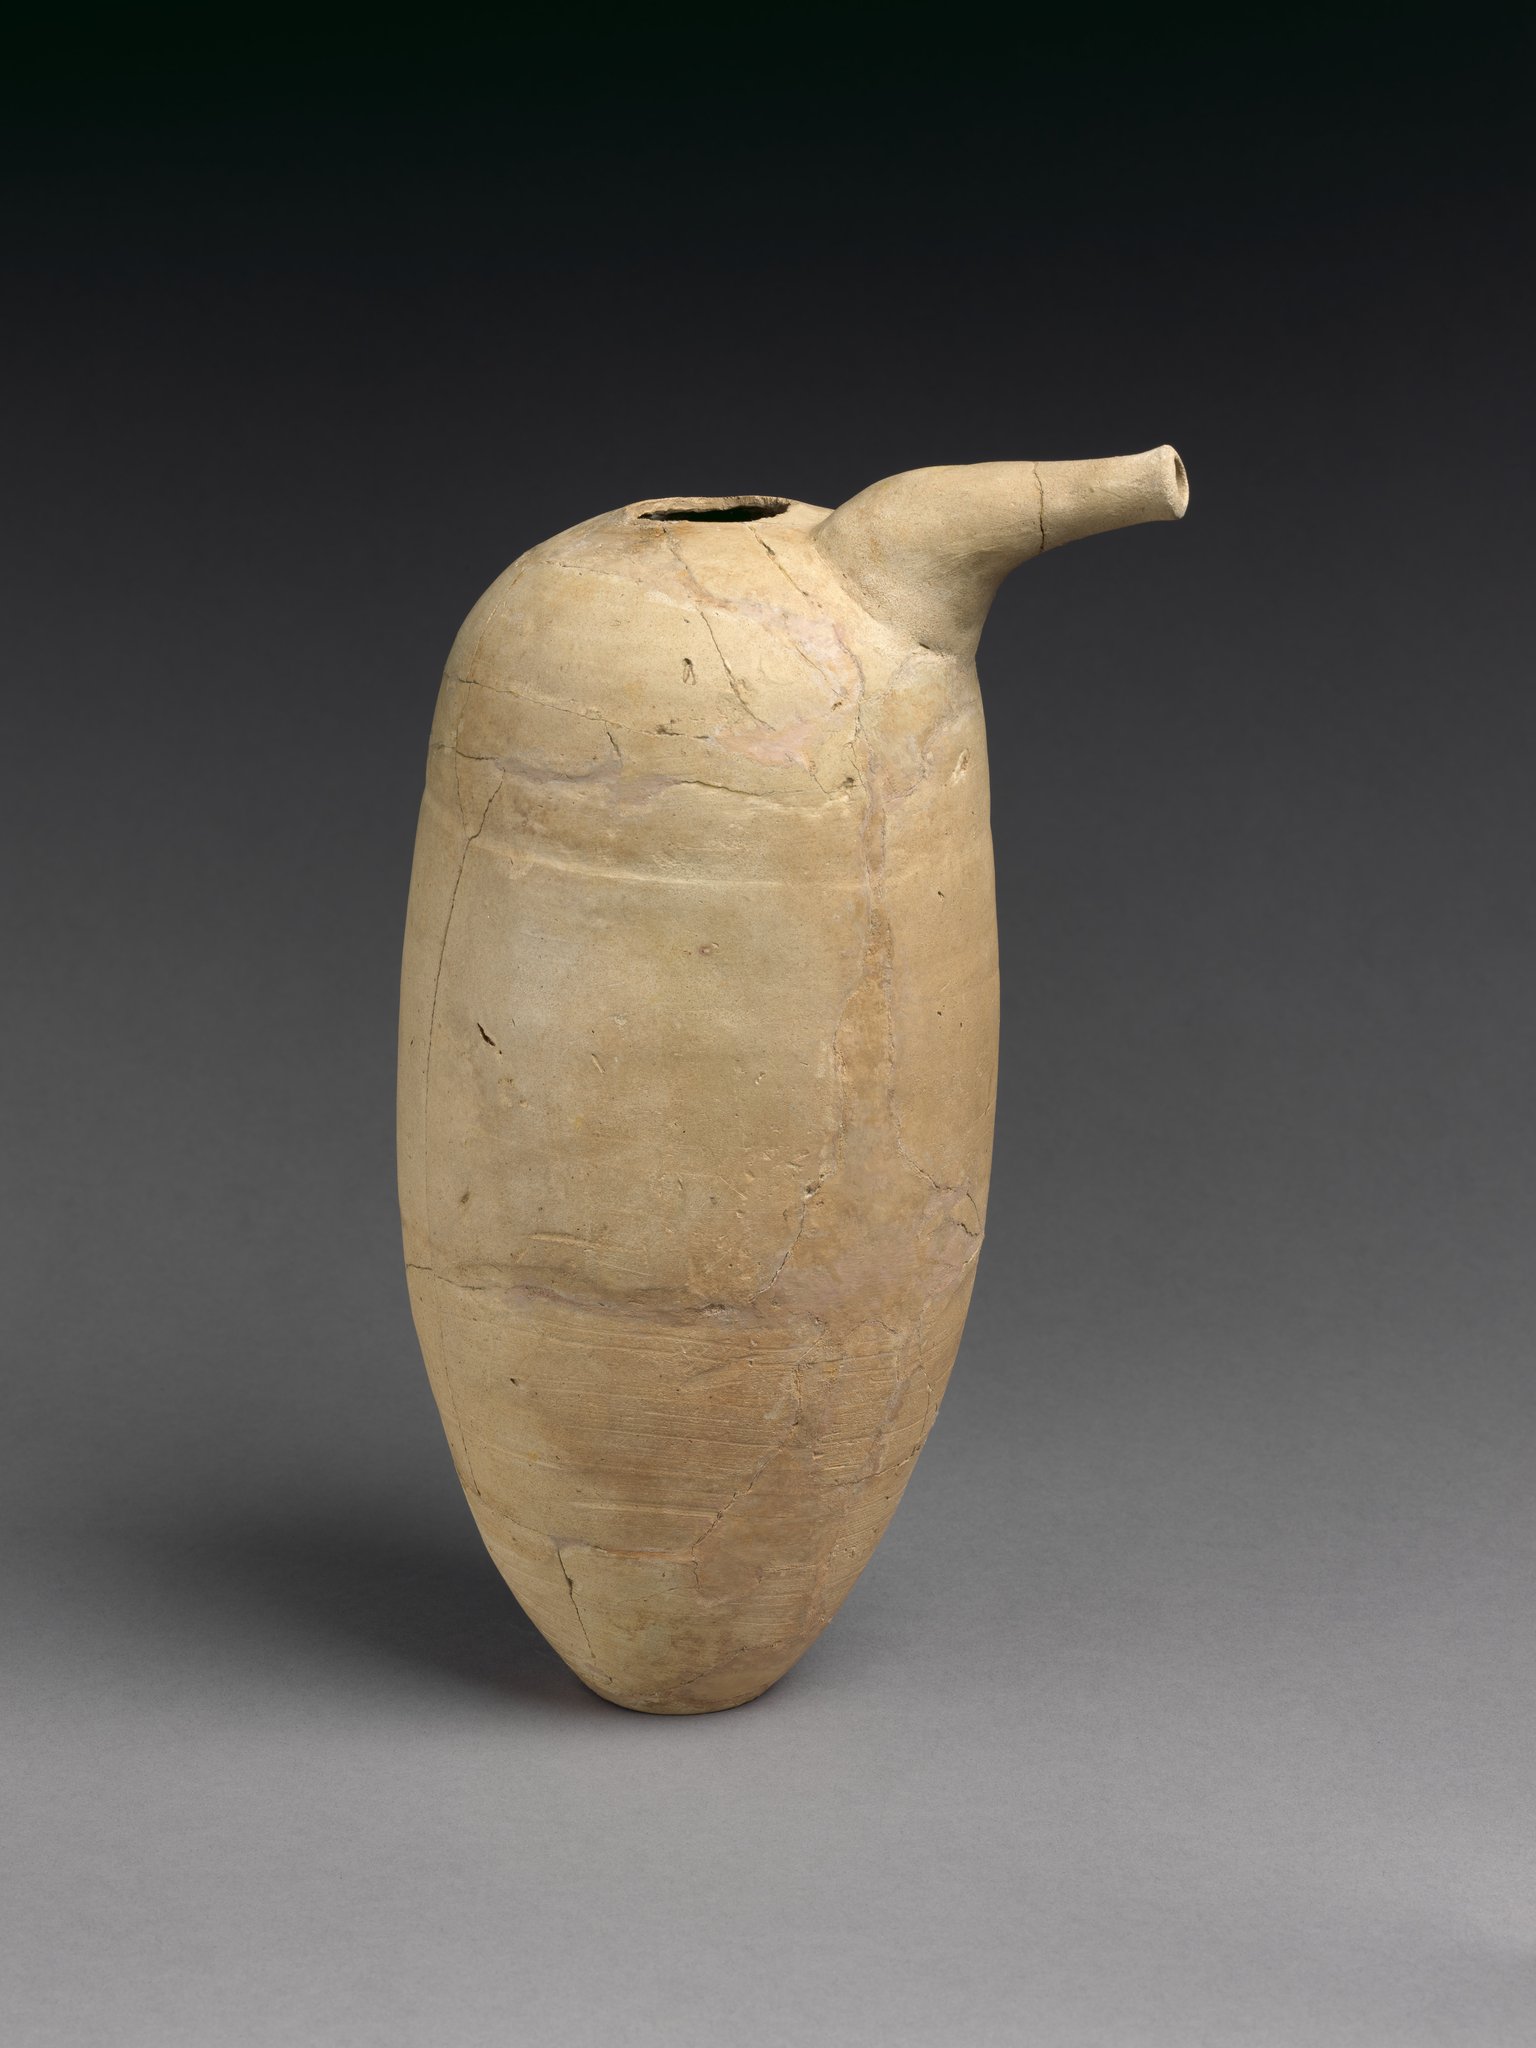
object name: jar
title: Spouted jar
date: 3400-3200 BCE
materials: ceramic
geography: mesopotamia